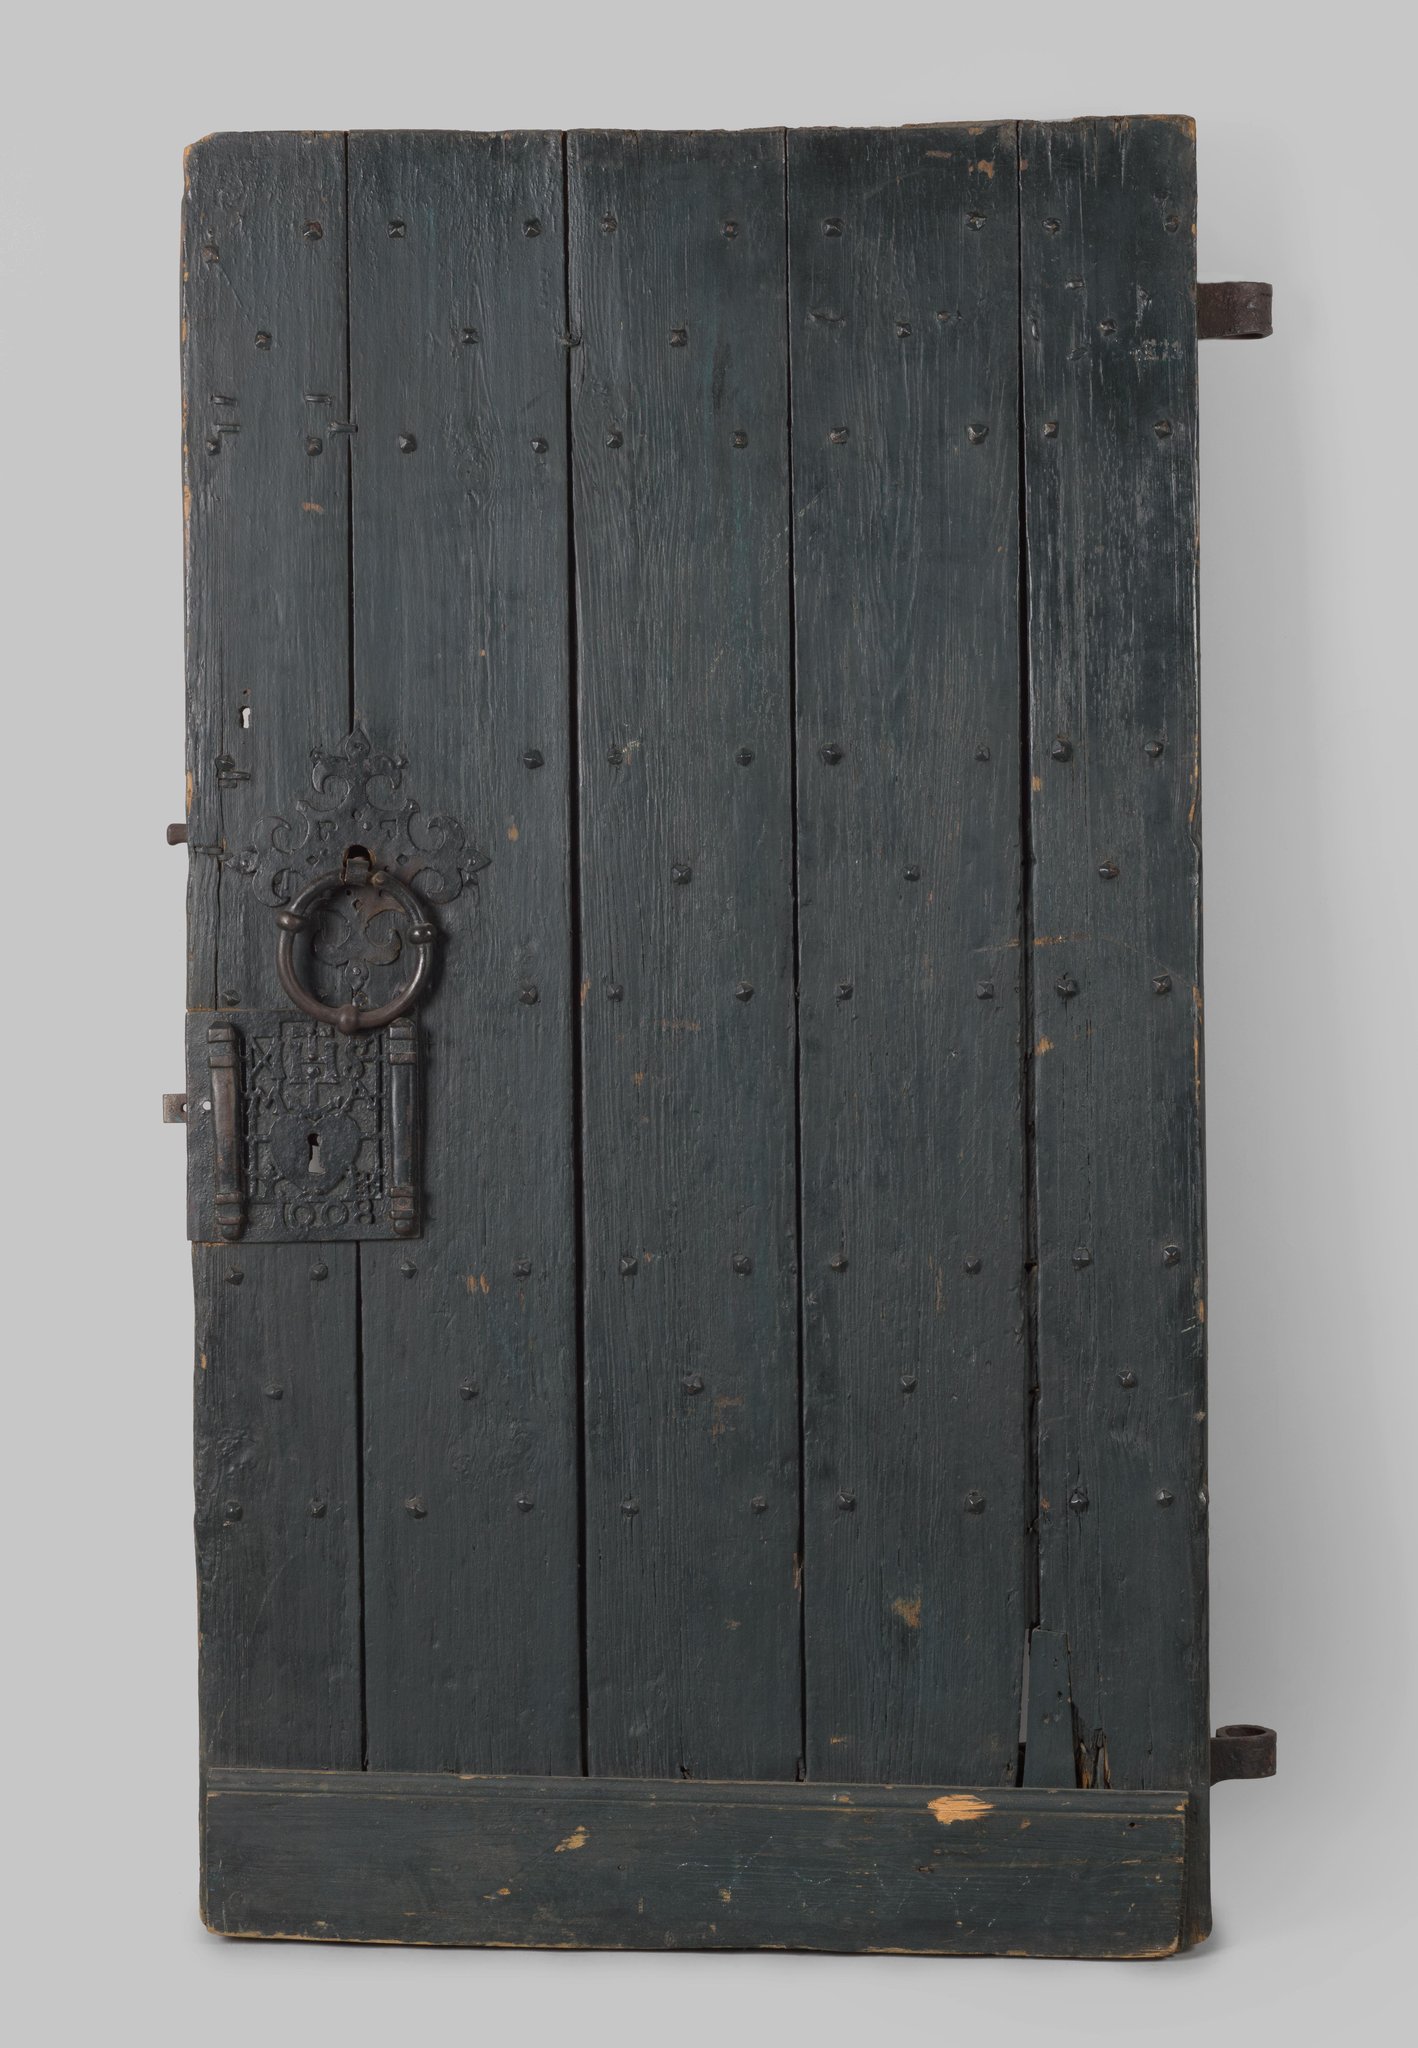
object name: architectural element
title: Deur met beslagen slotplaat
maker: Anonymous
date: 1608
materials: iron, wood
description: Deur van hout met metalen beslag en slotplaat. Afkomstig van een boerenwoning te Waspik.